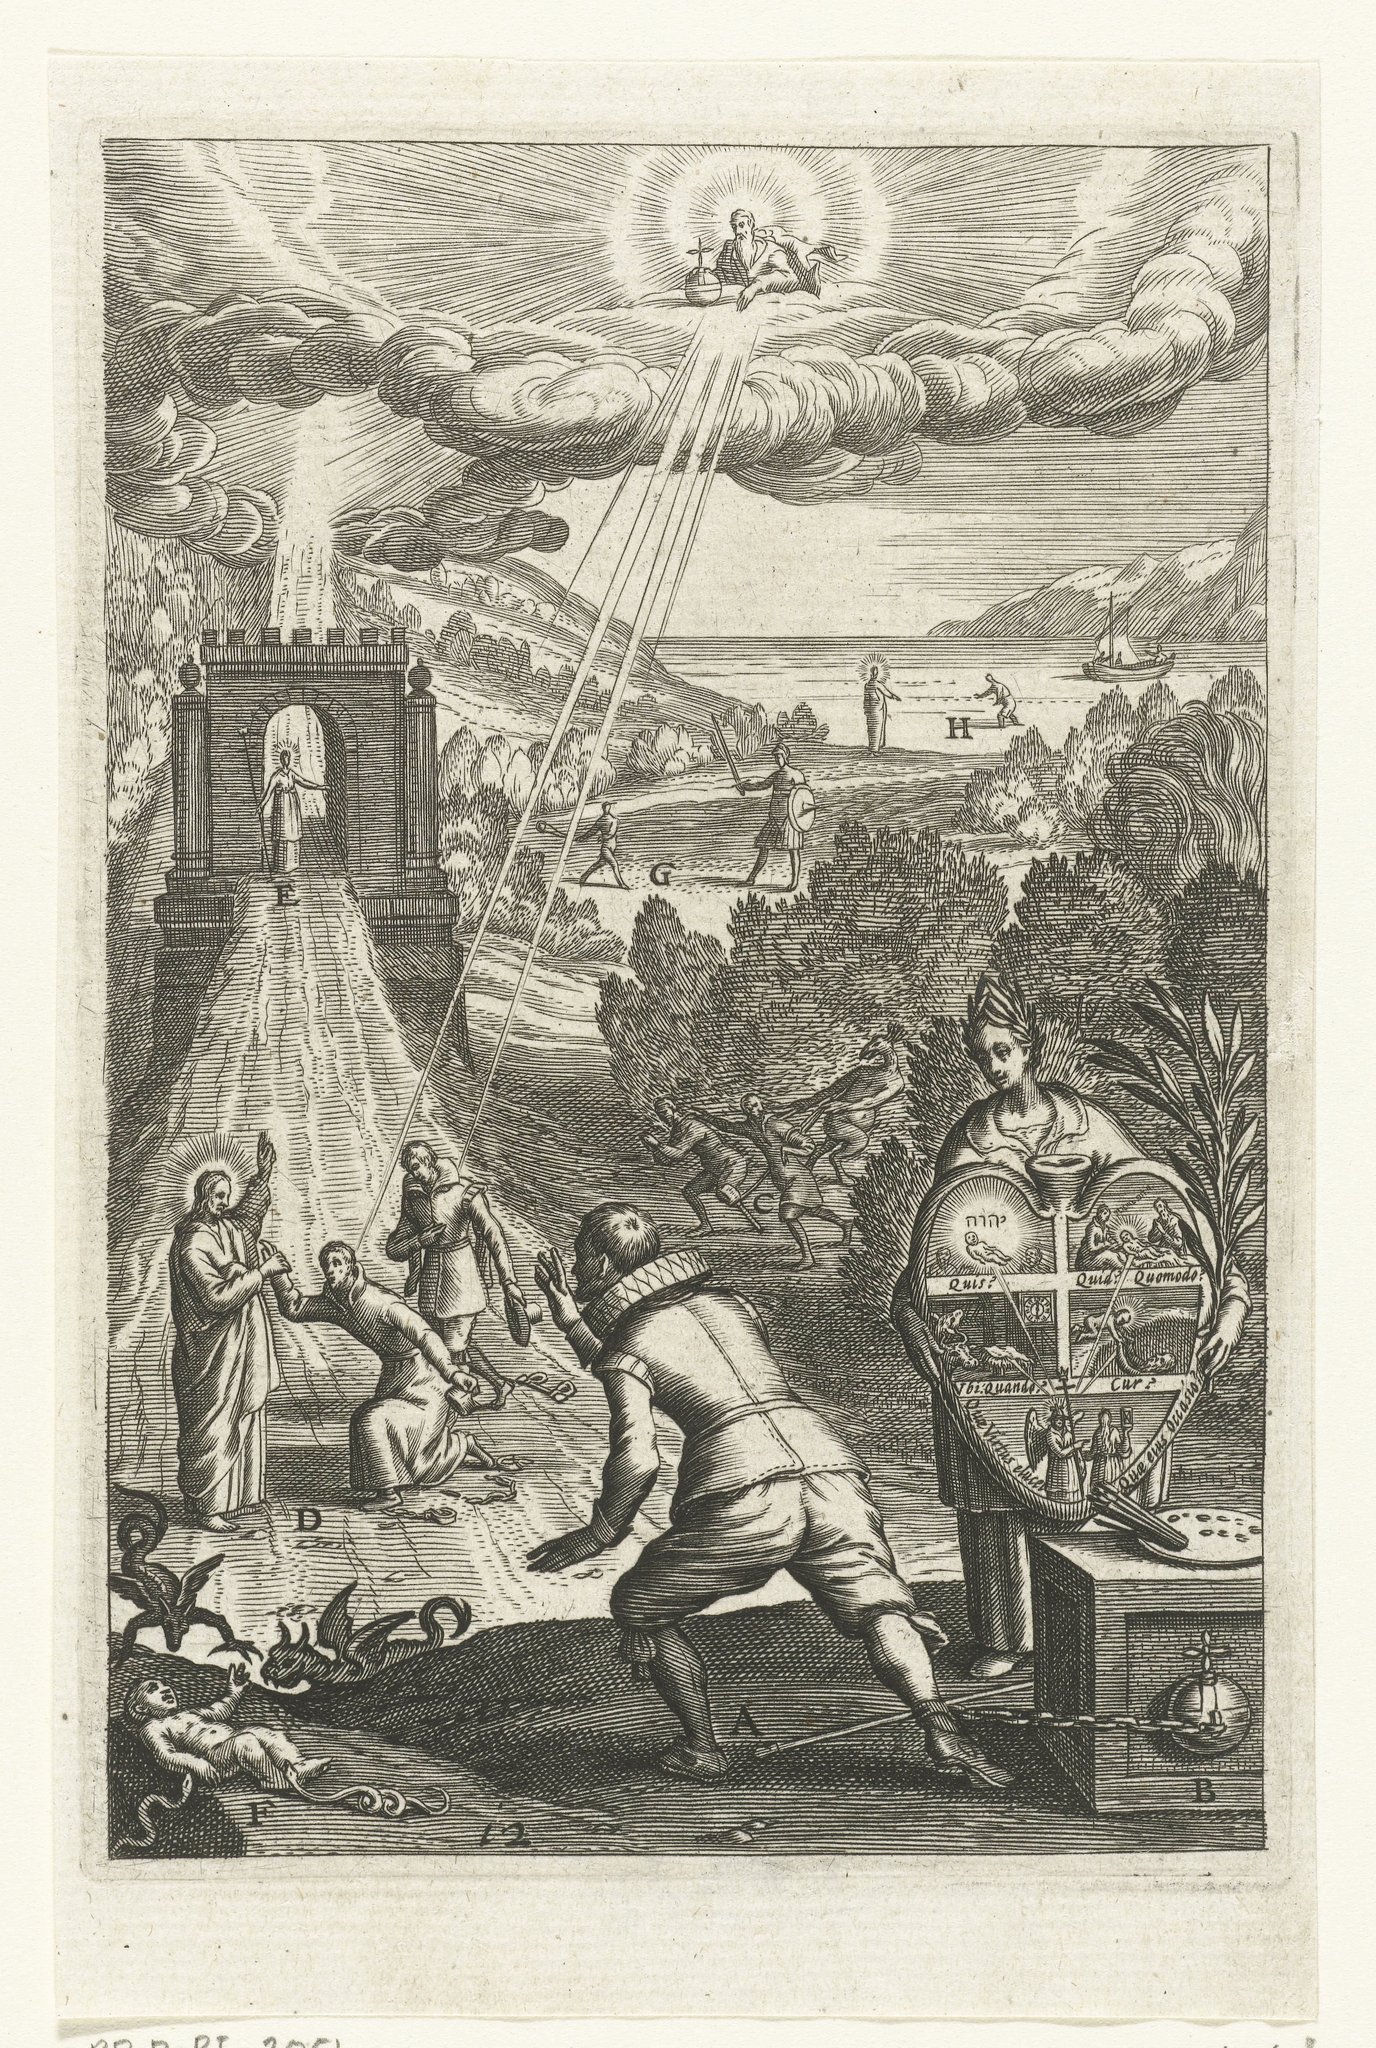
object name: print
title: Den wech des eeuwich levens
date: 1620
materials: paper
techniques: engraving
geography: low countries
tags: the life of man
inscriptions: collector's mark: Lugt 2228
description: Een geketende man kijkt naar een tafereel waarbij Christus twee gelovige mannen verlost van hun zonden en hun ketenen. Hun vertrouwen in God doet hen leven in deugd en stuurt hen op de juiste weg naar het eeuwige leven die op de achtergrond is weergegeven. Als voorbeeld wordt een bijbelscène aangehaald: de herdersjongen David won de strijd tegen de grote Goliath door zijn standvastige geloof.